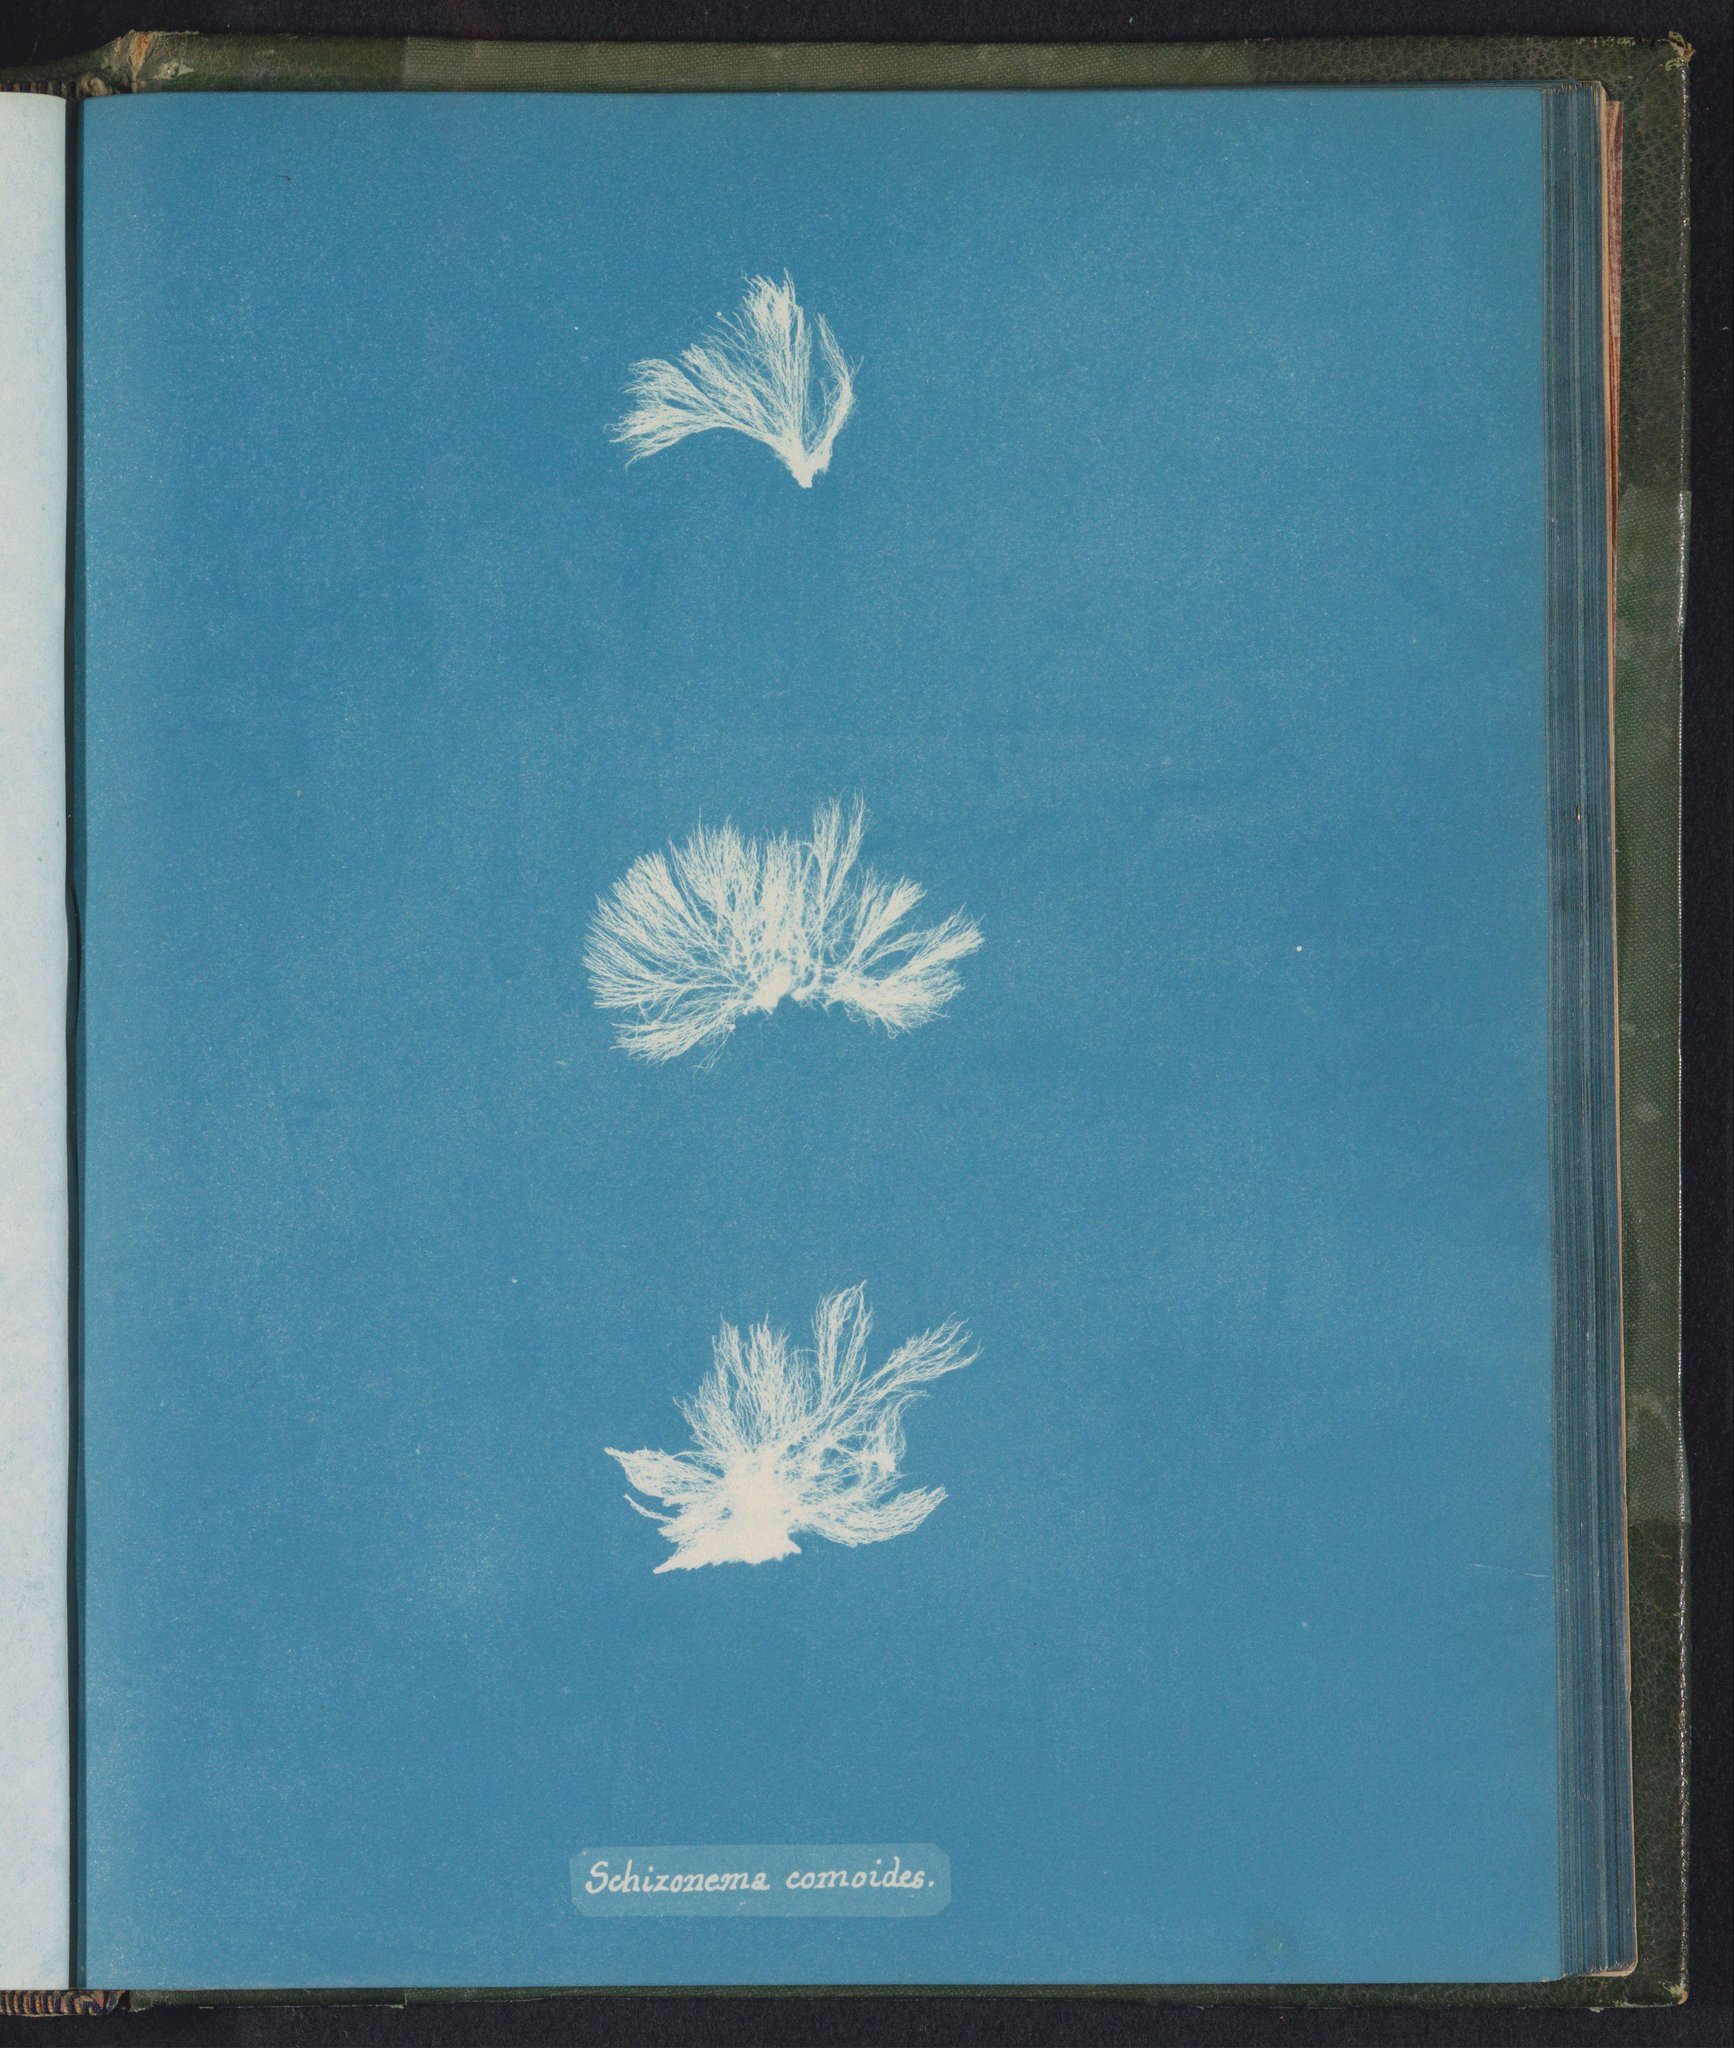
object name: page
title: Zeewier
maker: anna atkins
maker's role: fotograaf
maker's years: 1799-1871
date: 1843-1853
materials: photographic support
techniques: cyanotype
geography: united kingdom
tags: algae, seaweed